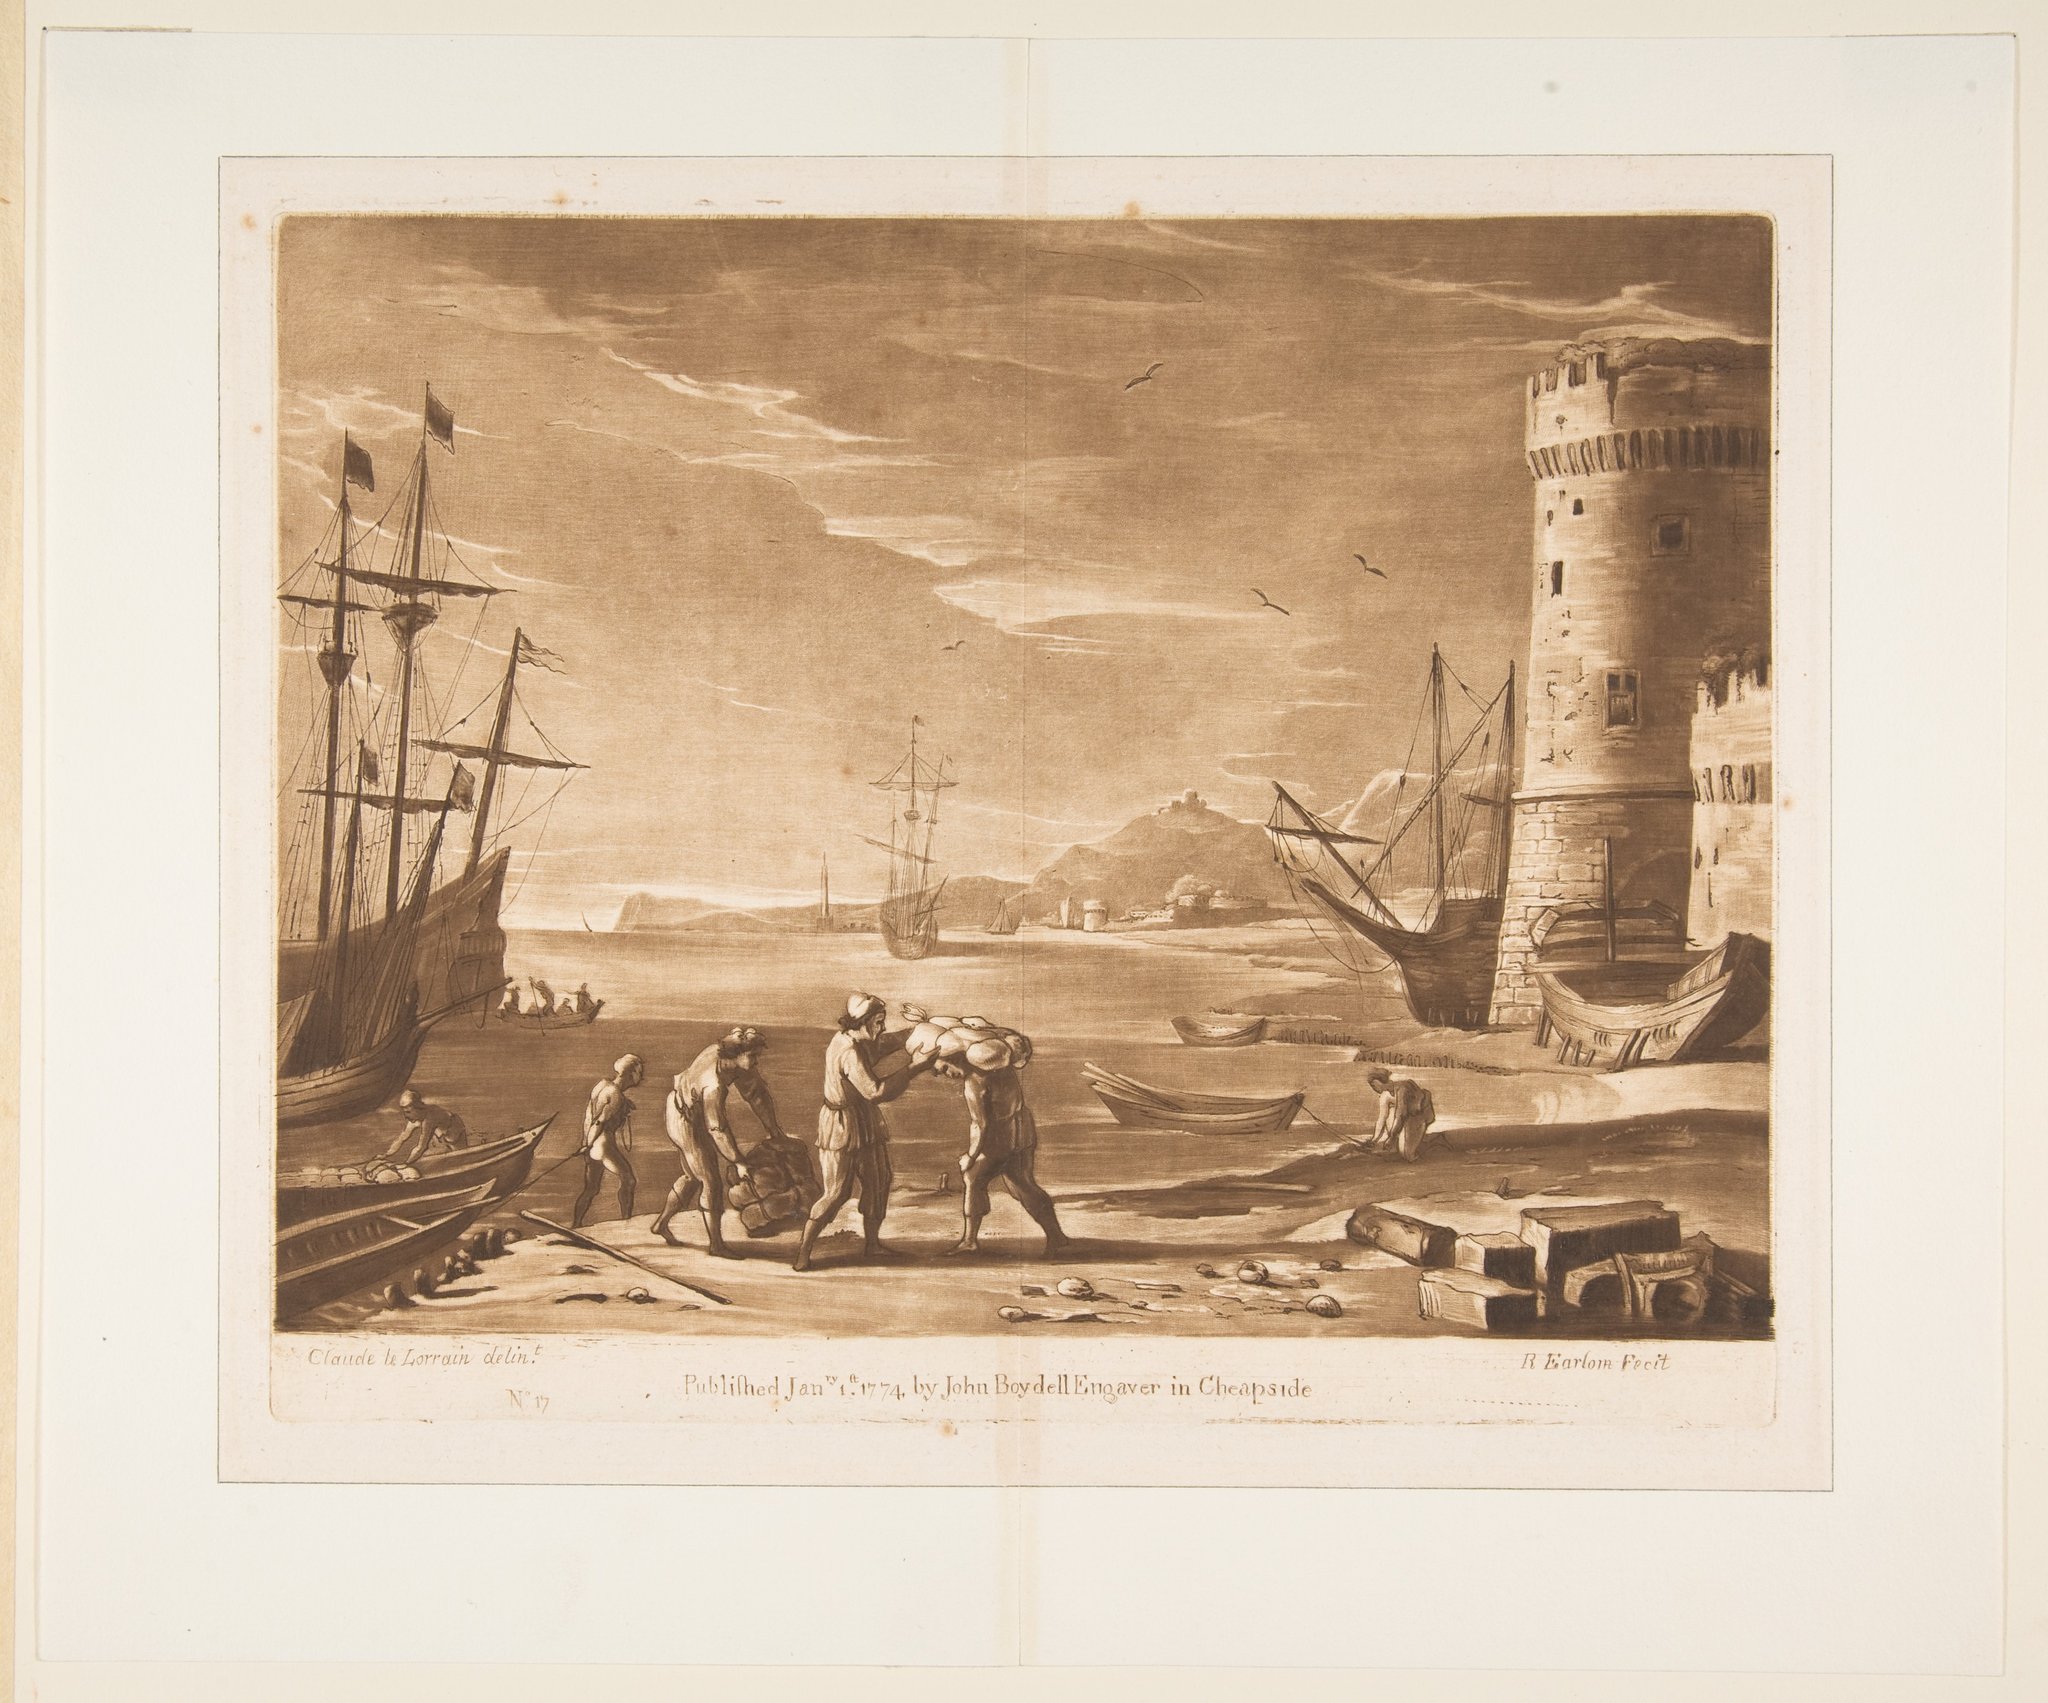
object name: print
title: Seaport with Sailors Loading Merchandise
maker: richard earlom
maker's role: engraver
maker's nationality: british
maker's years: 1743-1822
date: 1774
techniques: mezzotint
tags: towers,men,boats,ships